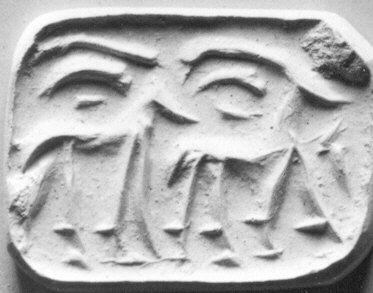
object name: stamp seal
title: Gable seal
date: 4000-3500 BCE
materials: mineral, stone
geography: northern syria or southeastern anatolia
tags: animals